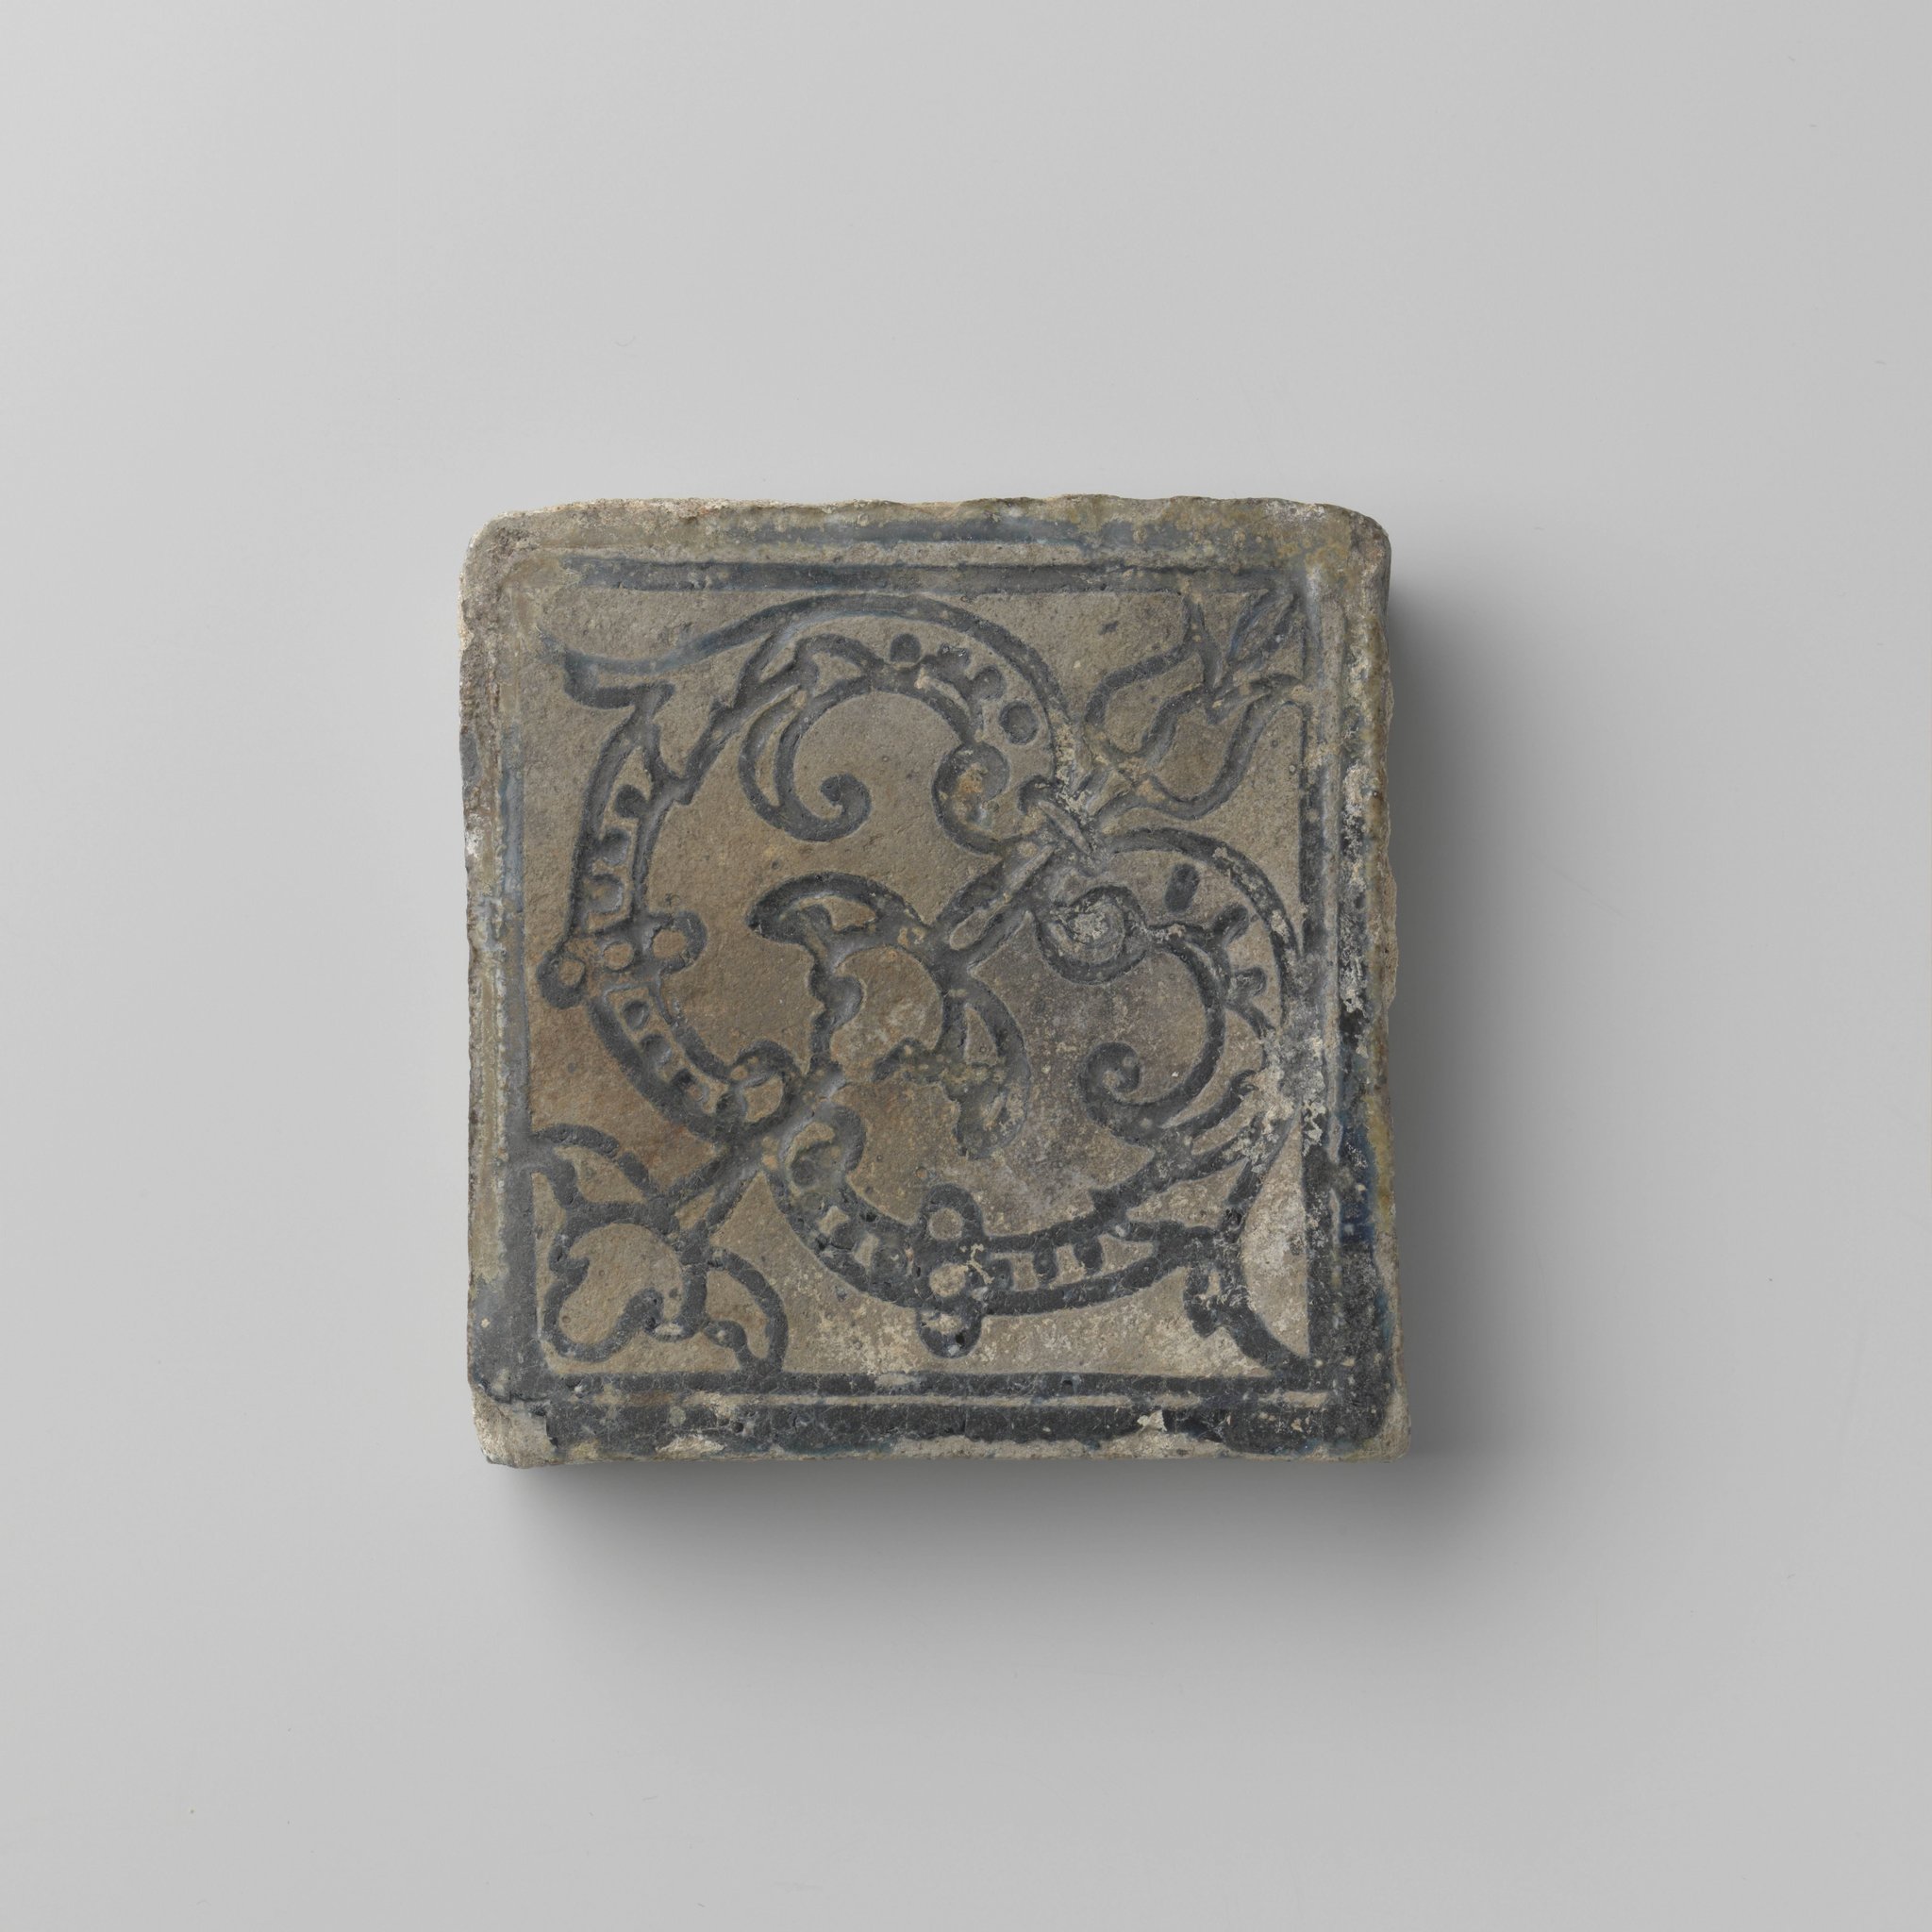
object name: tile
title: Tegel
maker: Anonymous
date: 1500-1600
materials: earthenware, glaze, pitch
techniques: inlay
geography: france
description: Tegel versierd met voluten diagonaal geplaatst.